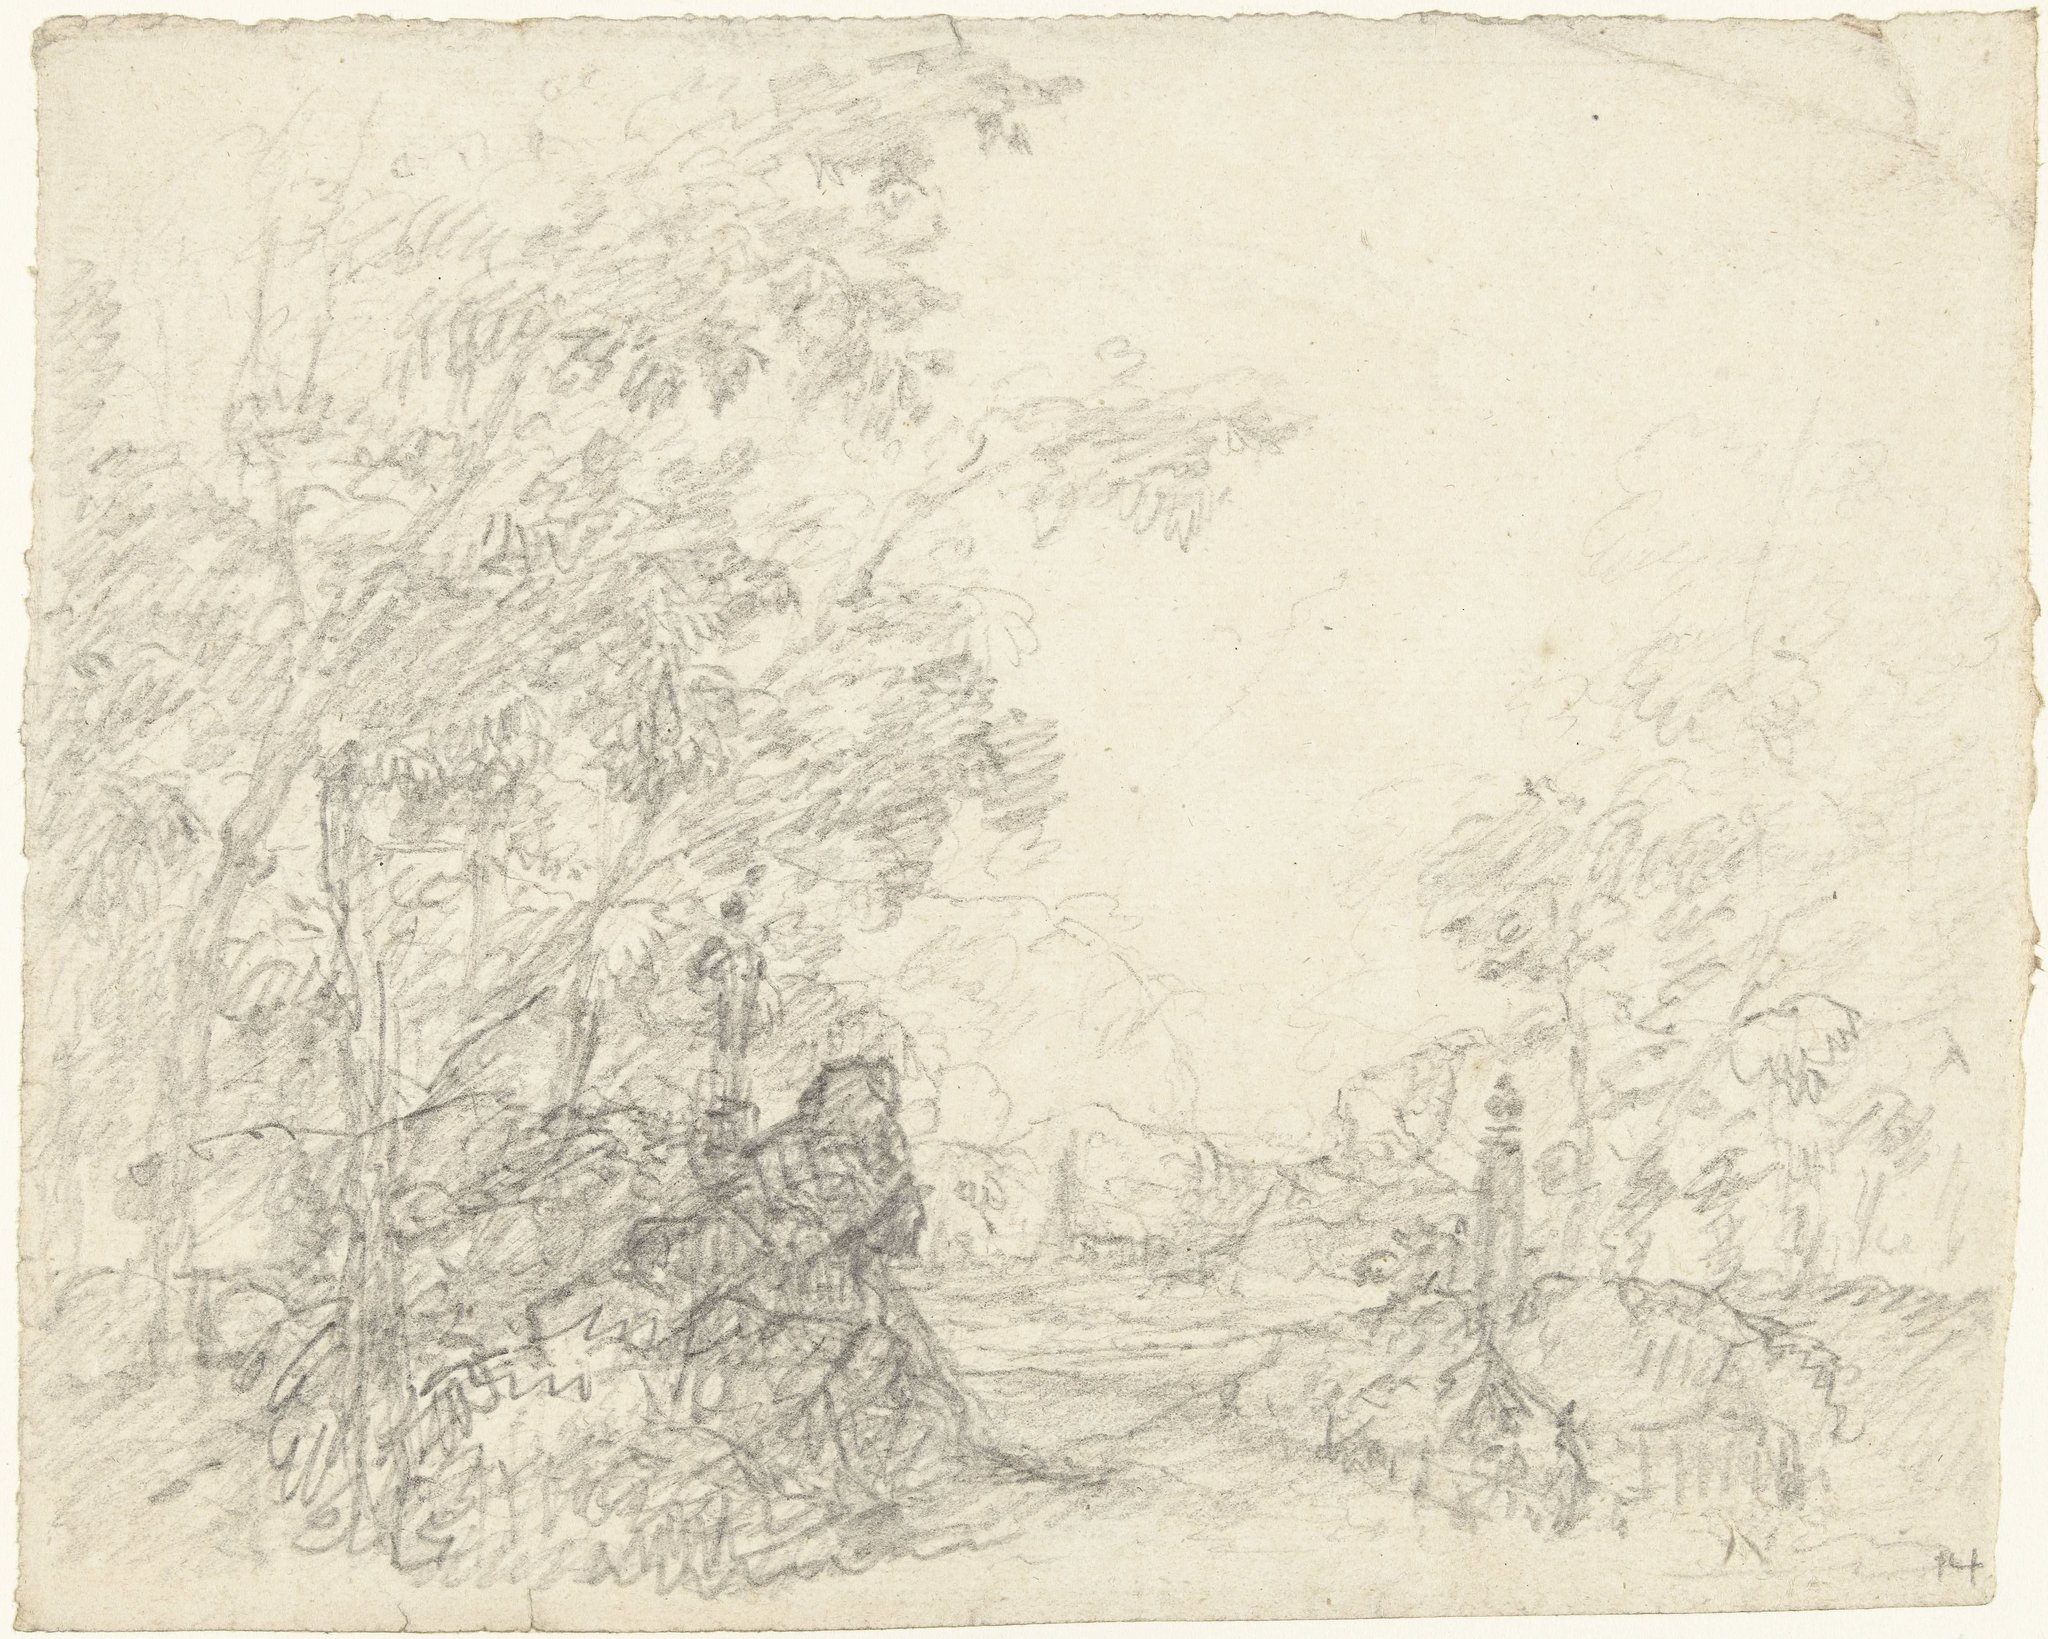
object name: design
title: Landschap met een sculptuur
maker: dionys van nijmegen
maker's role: draughtsman, painter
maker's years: 1705-1798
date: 1715-1798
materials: paper, pencil